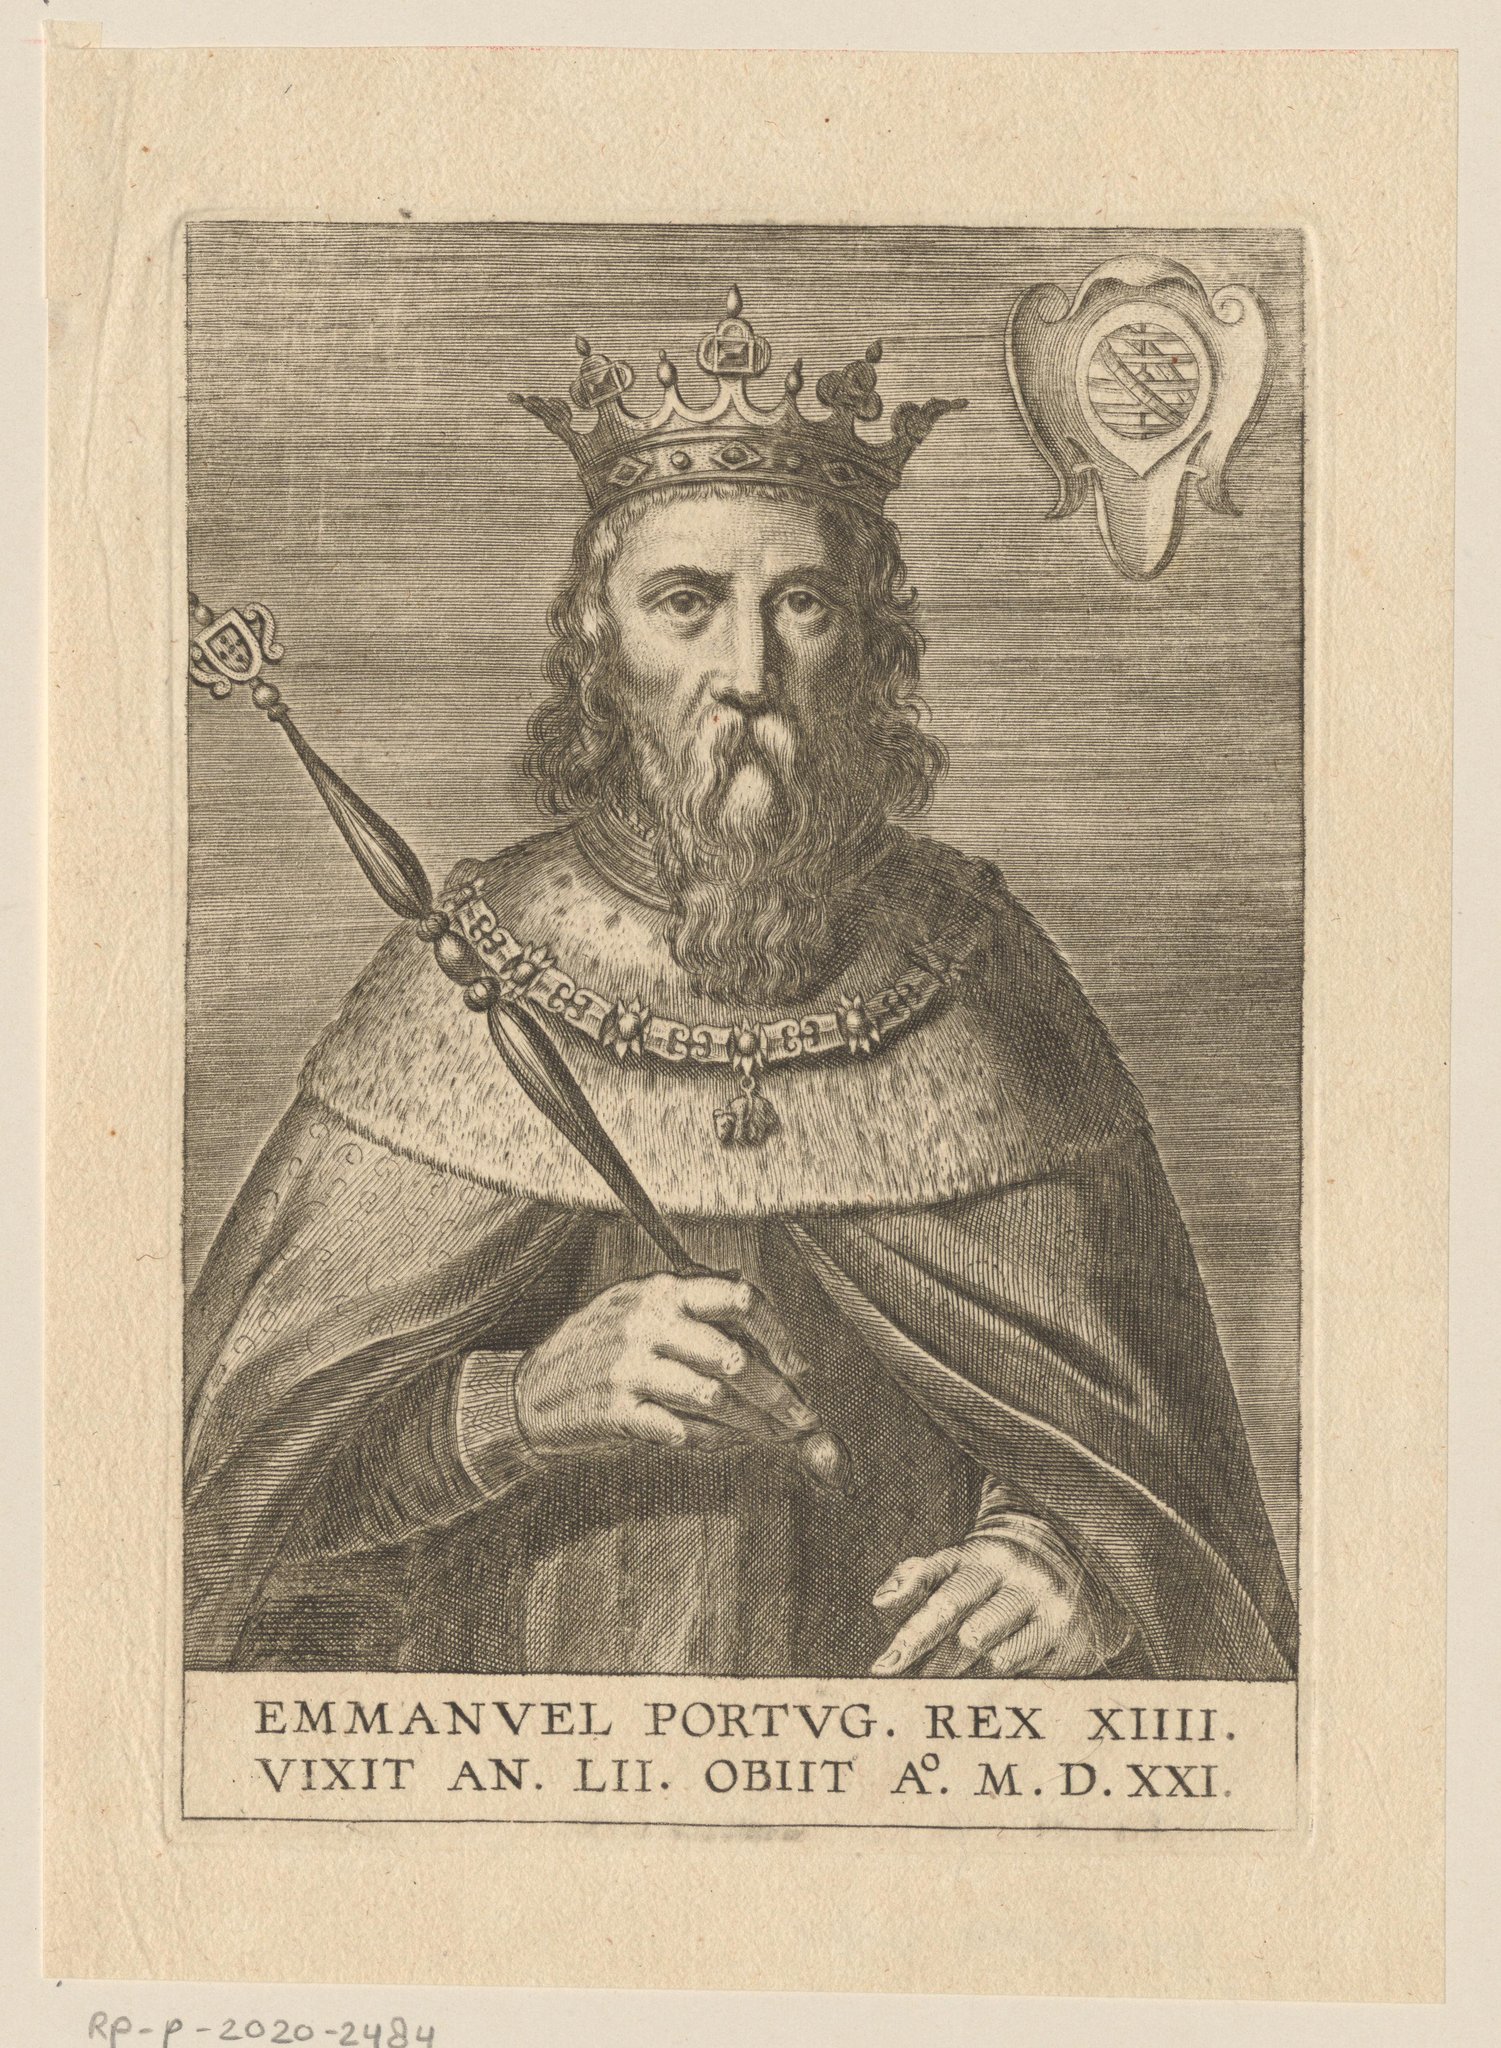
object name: print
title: Portret van Emanuel I van Portugal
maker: Anonymous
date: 1600-1670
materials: paper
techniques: engraving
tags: historical persons, knighthood order of the golden fleece, king